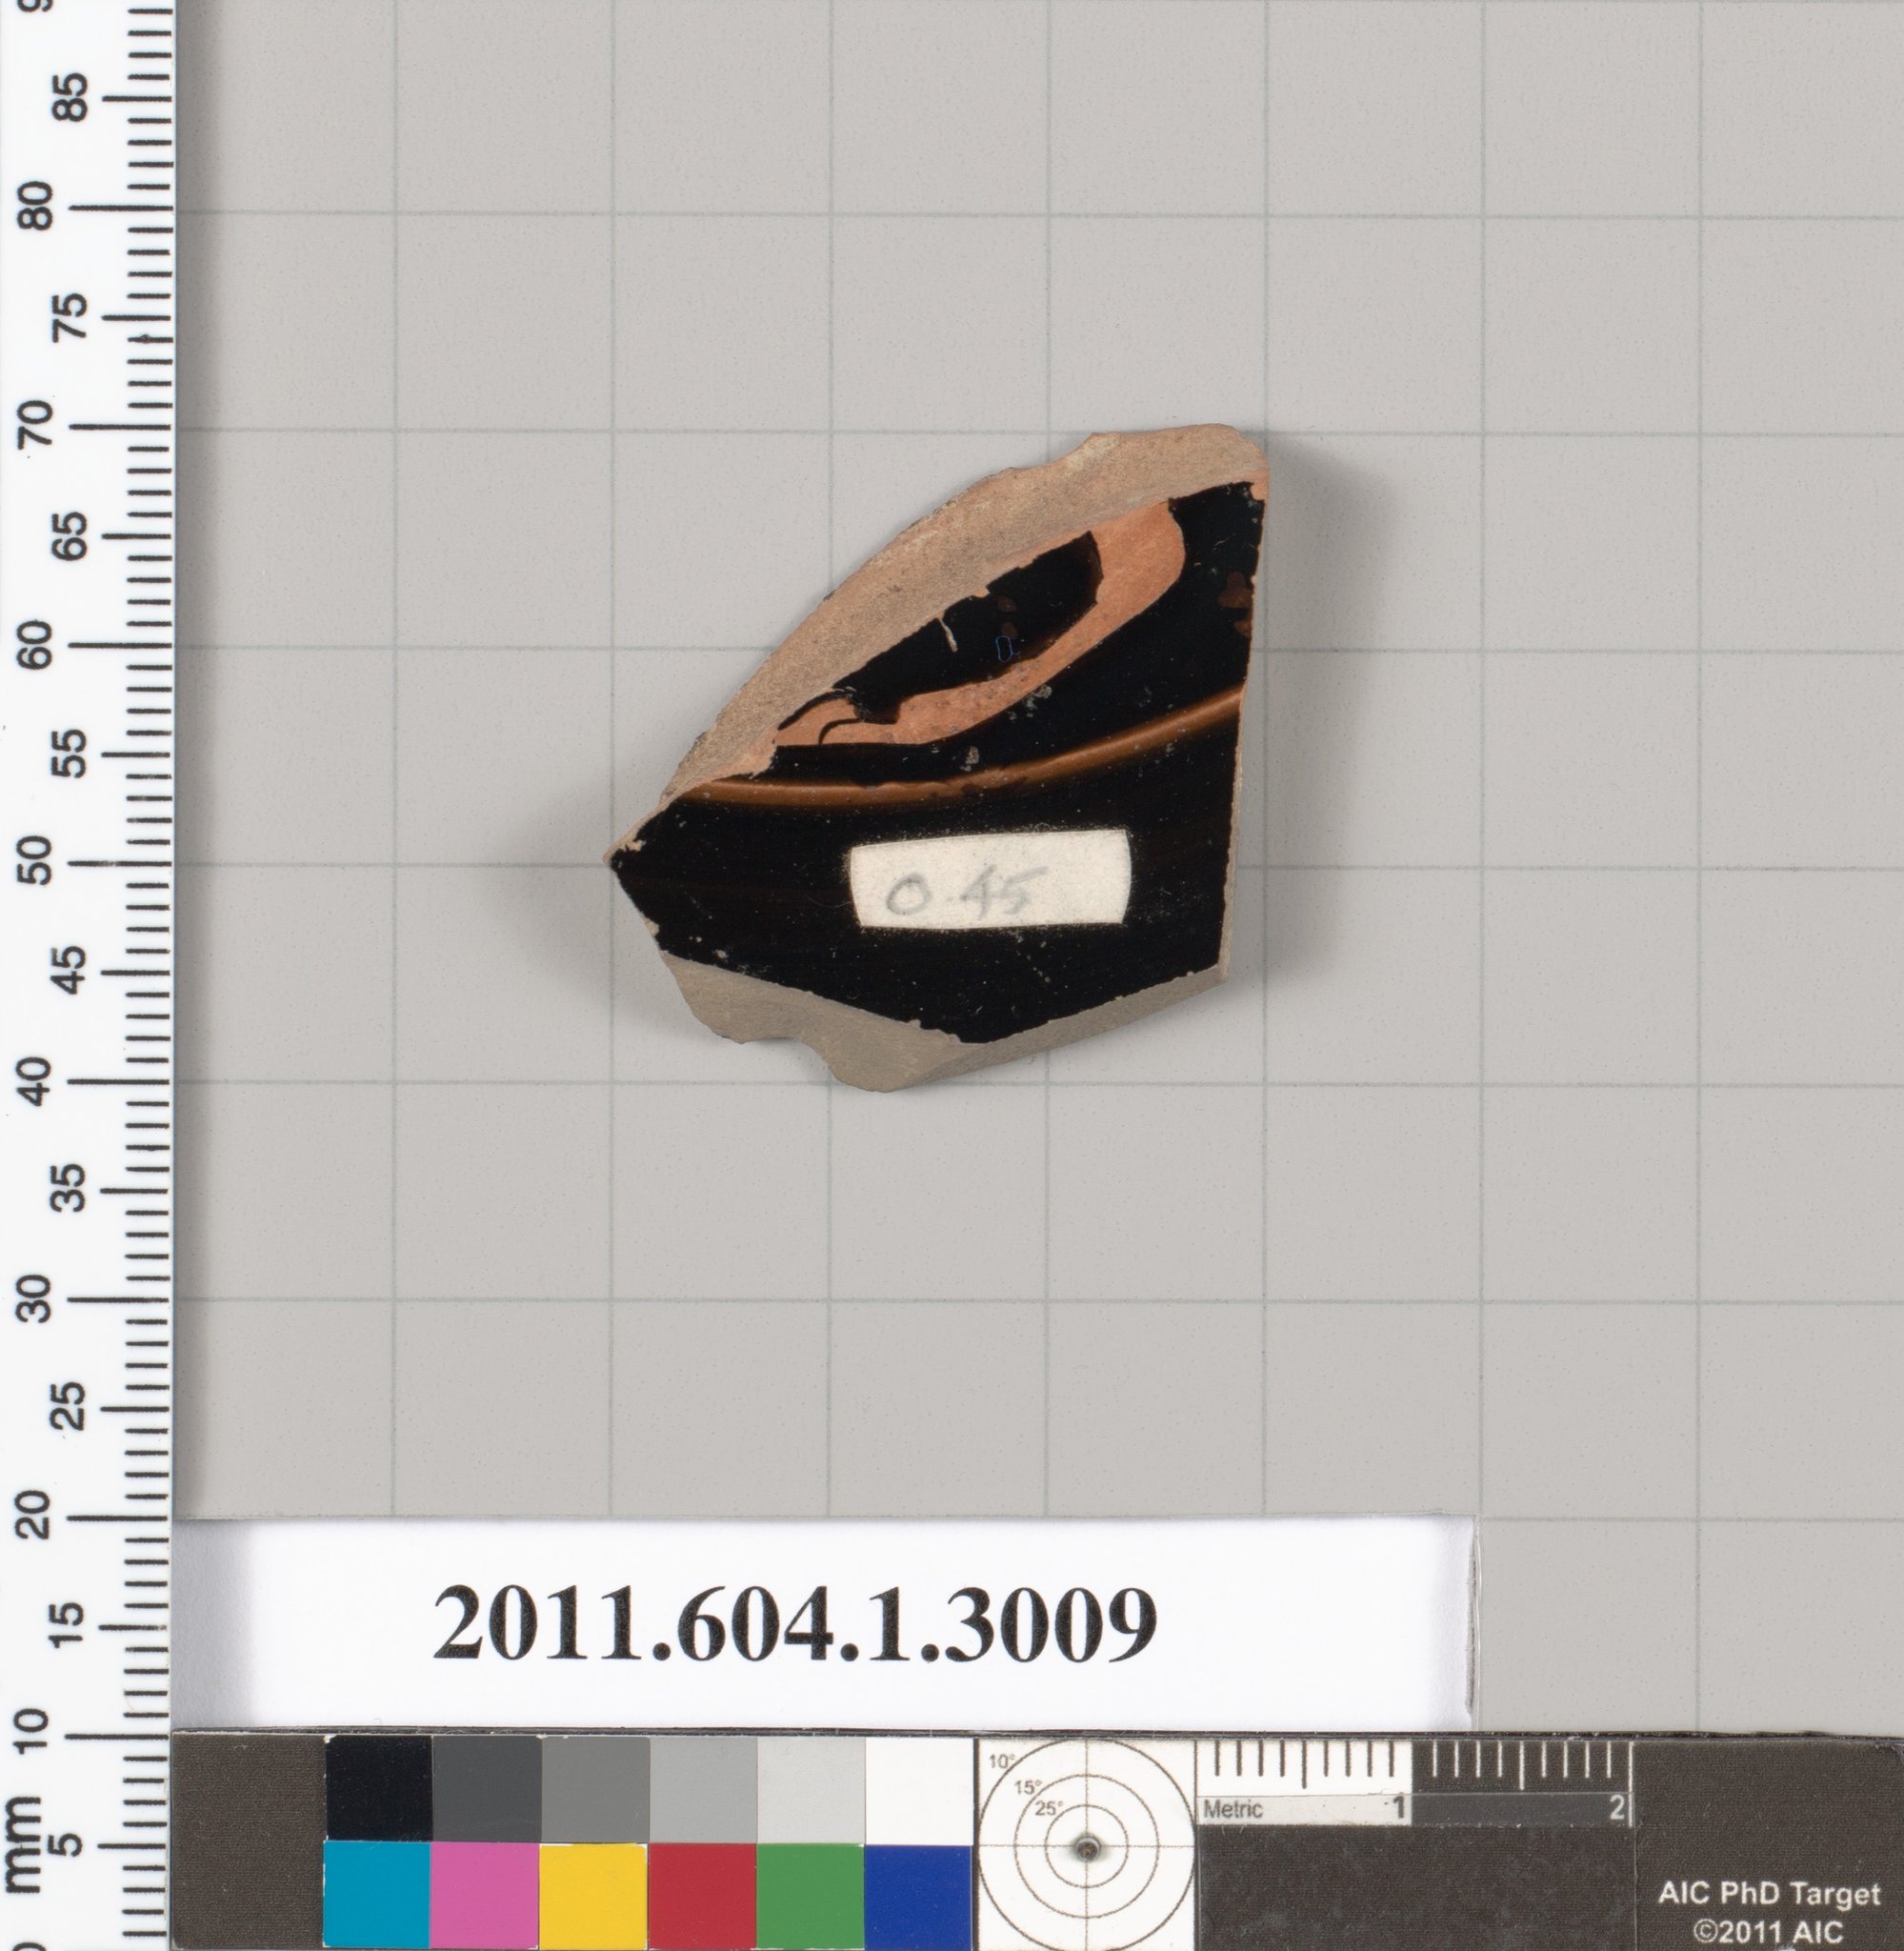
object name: kylix fragment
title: Terracotta fragment of a kylix (drinking cup)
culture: greek, attic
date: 510-490 BCE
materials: terracotta